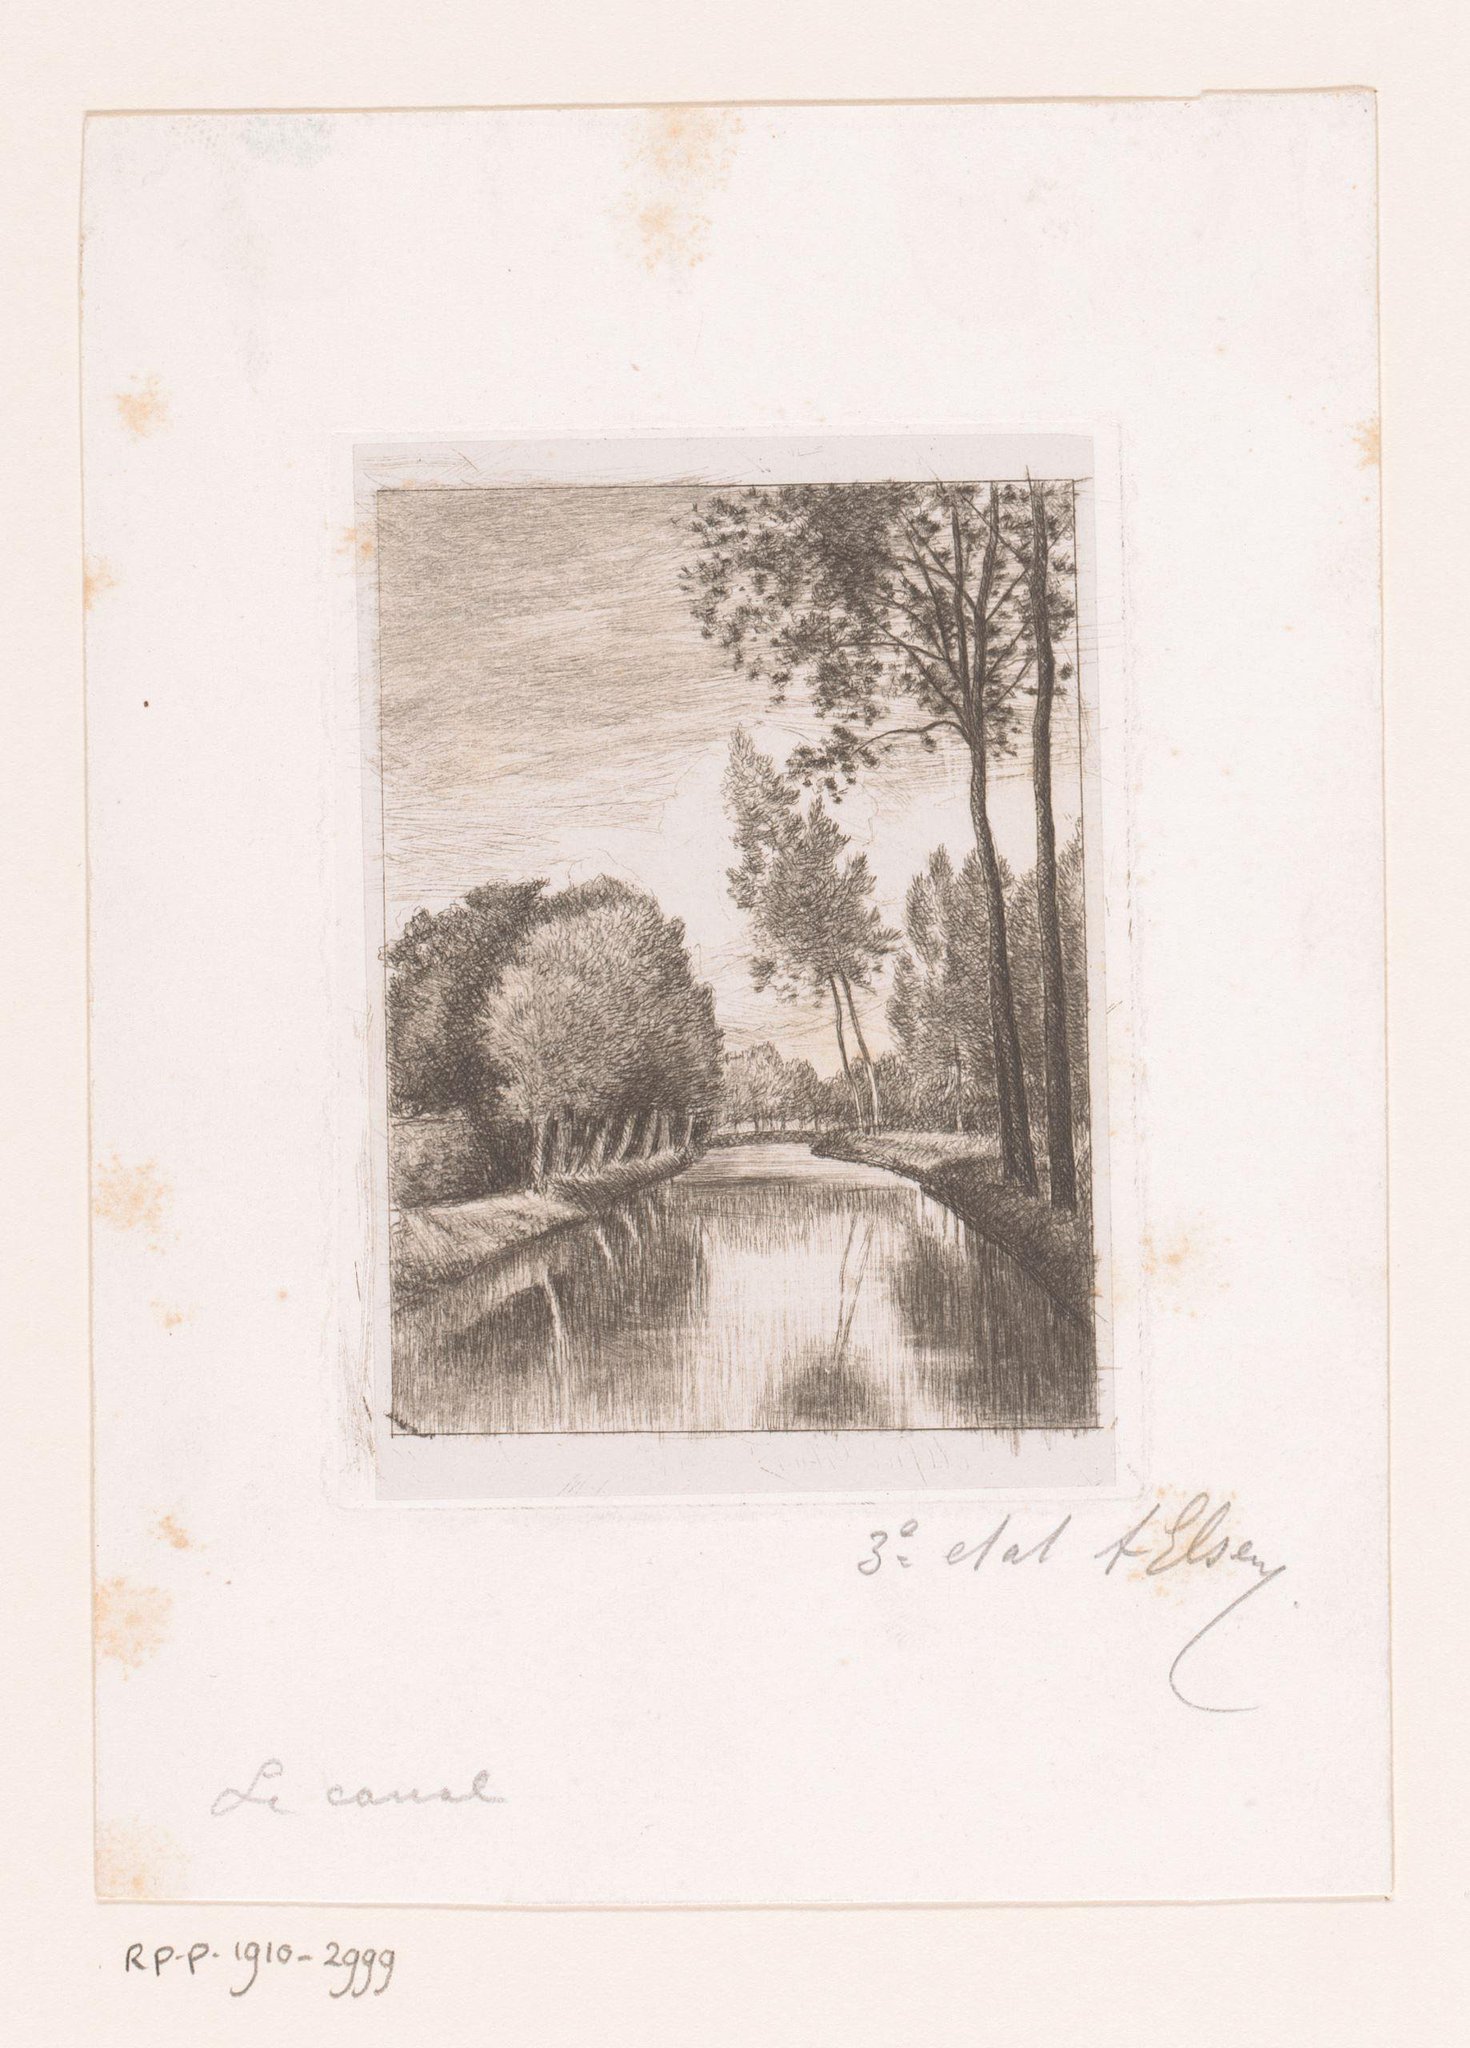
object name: print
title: Kanaal met begroeiing langs de oevers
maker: alfred elsen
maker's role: painter, print maker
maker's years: 1850-1914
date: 1860-1910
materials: paper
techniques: etching, intaglio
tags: canal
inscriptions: collector's mark: Lugt 2228, inscription: ‘3e etat’